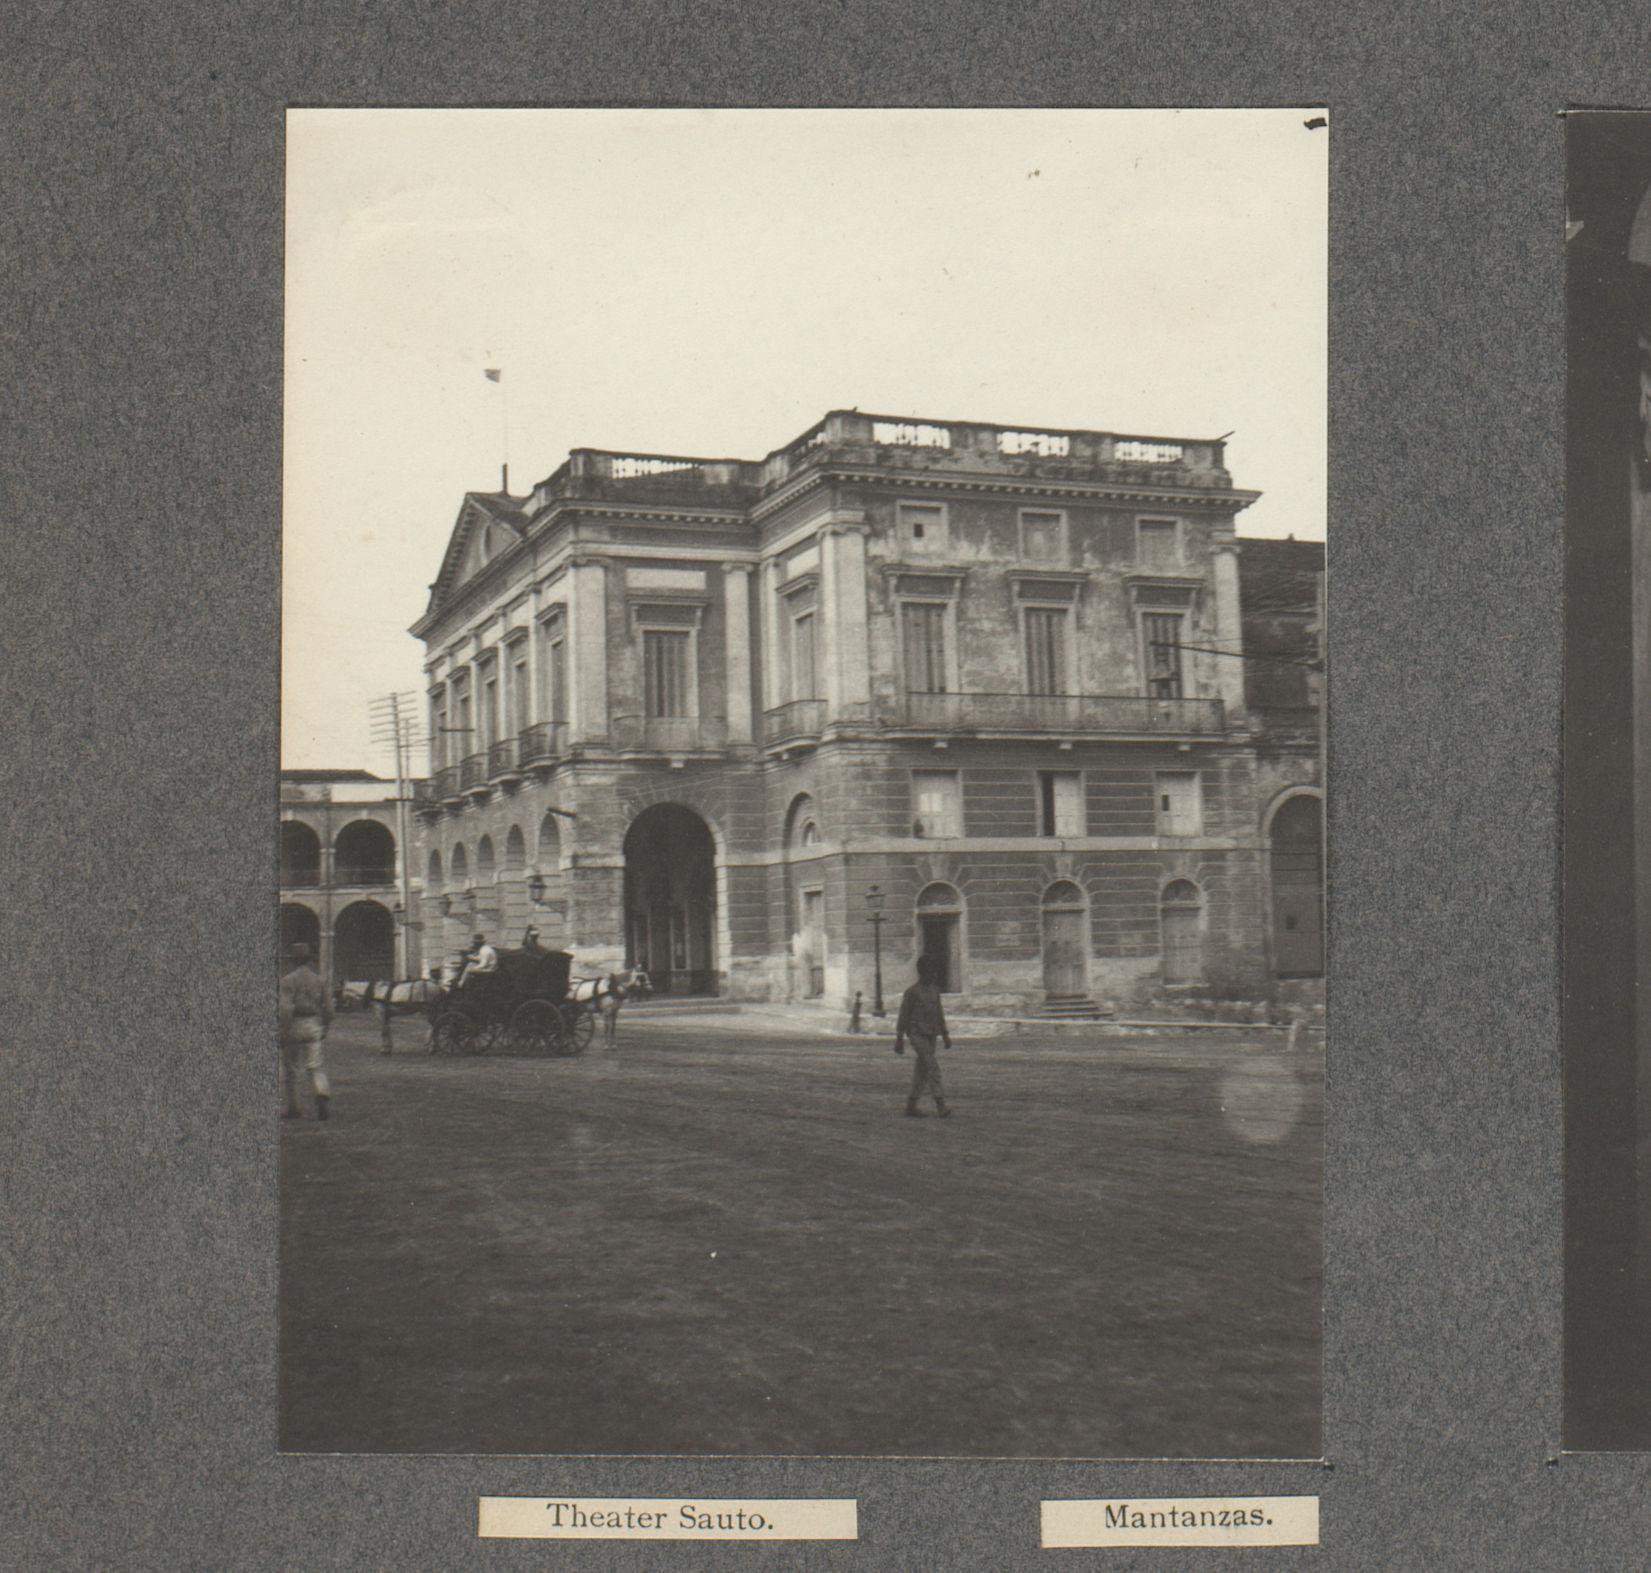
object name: photograph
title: Theater Santo. Mantanzas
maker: Anonymous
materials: paper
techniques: platinum process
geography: matanzas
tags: theatre (building), exterior ~ representation of a building